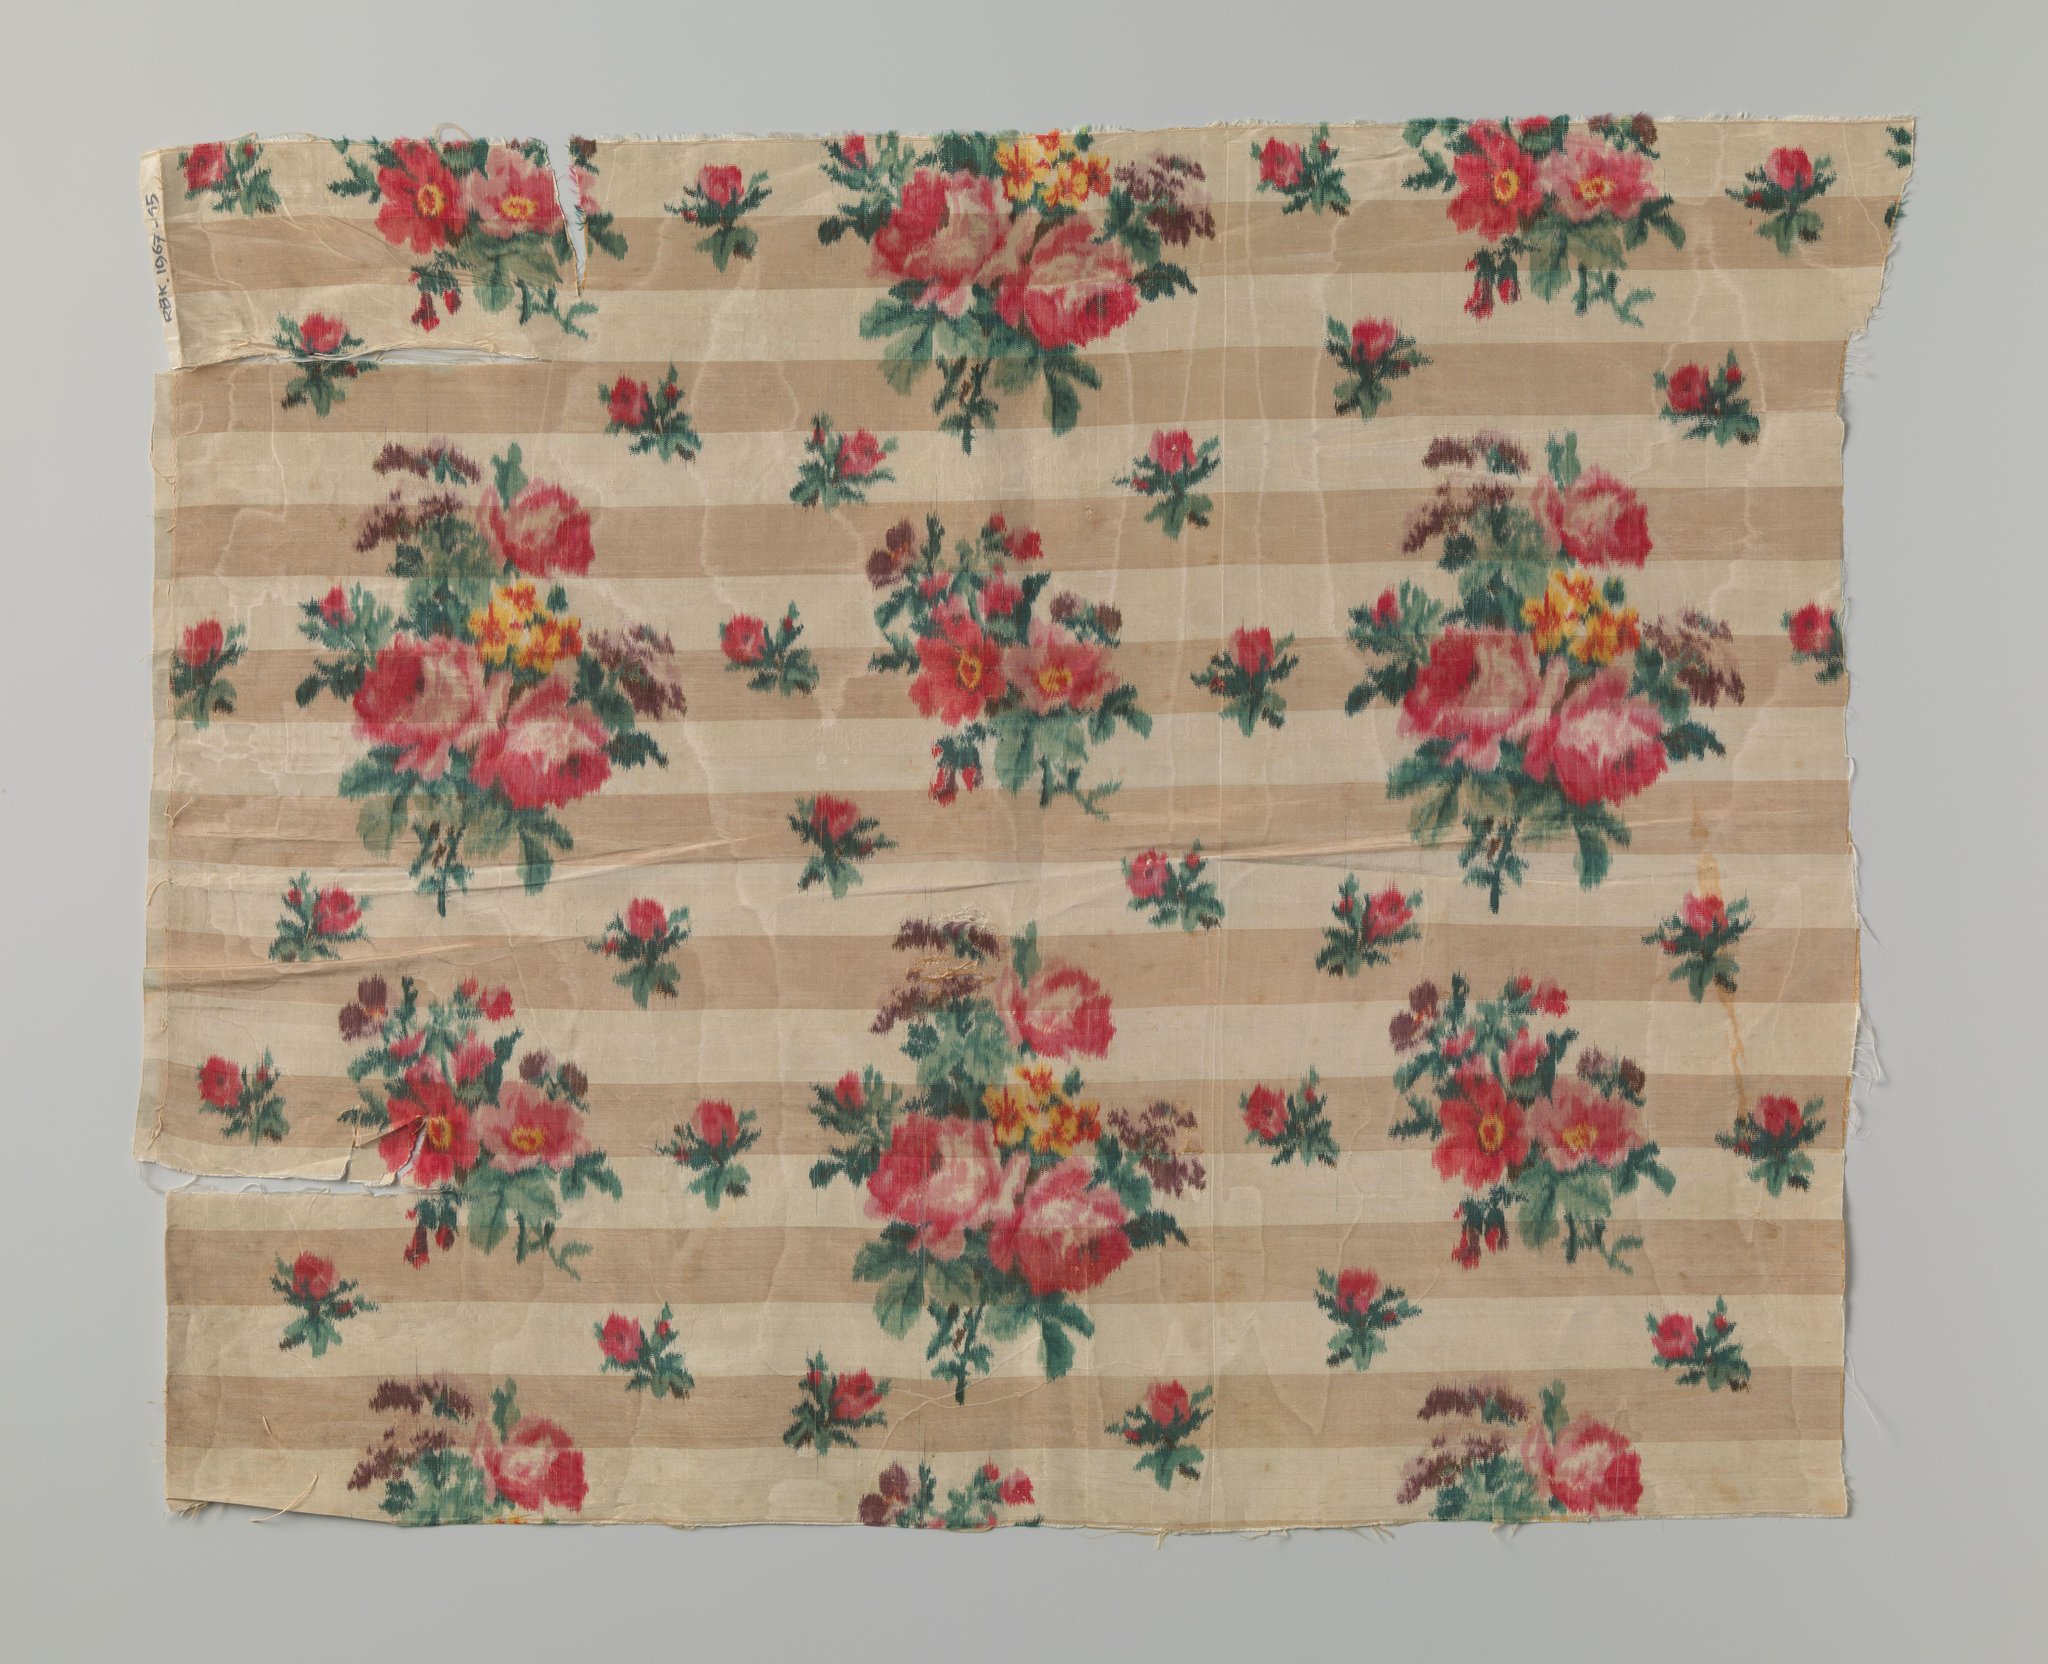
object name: stoelzitting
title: Als stoelzitting geknipt fragment chiné-zijde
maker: Anonymous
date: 1800-1899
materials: silk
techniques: embroidered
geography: france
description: Fragment chiné-zijde met bloemtoefjes op gestreepte fond. Model: als stoelzitting geknipt met twee insnijdingen voor de leuning. Fond van dwarse strepen in beige en roomwit, in gros de Tours (ripszijde) met moiré, dat ter weerszijden van een stofvouw, symmetrisch is ontstaan. Patroon: twee soorten bloemruikers: een groot van roserode rozen waartussen geel/rode en lila/paarse bloemen zijn geschikt. Een kleinere ruiker bestaat uit rose en rode open bloemen met gele harten. Losse knoppen staan ertussen gestrooid.